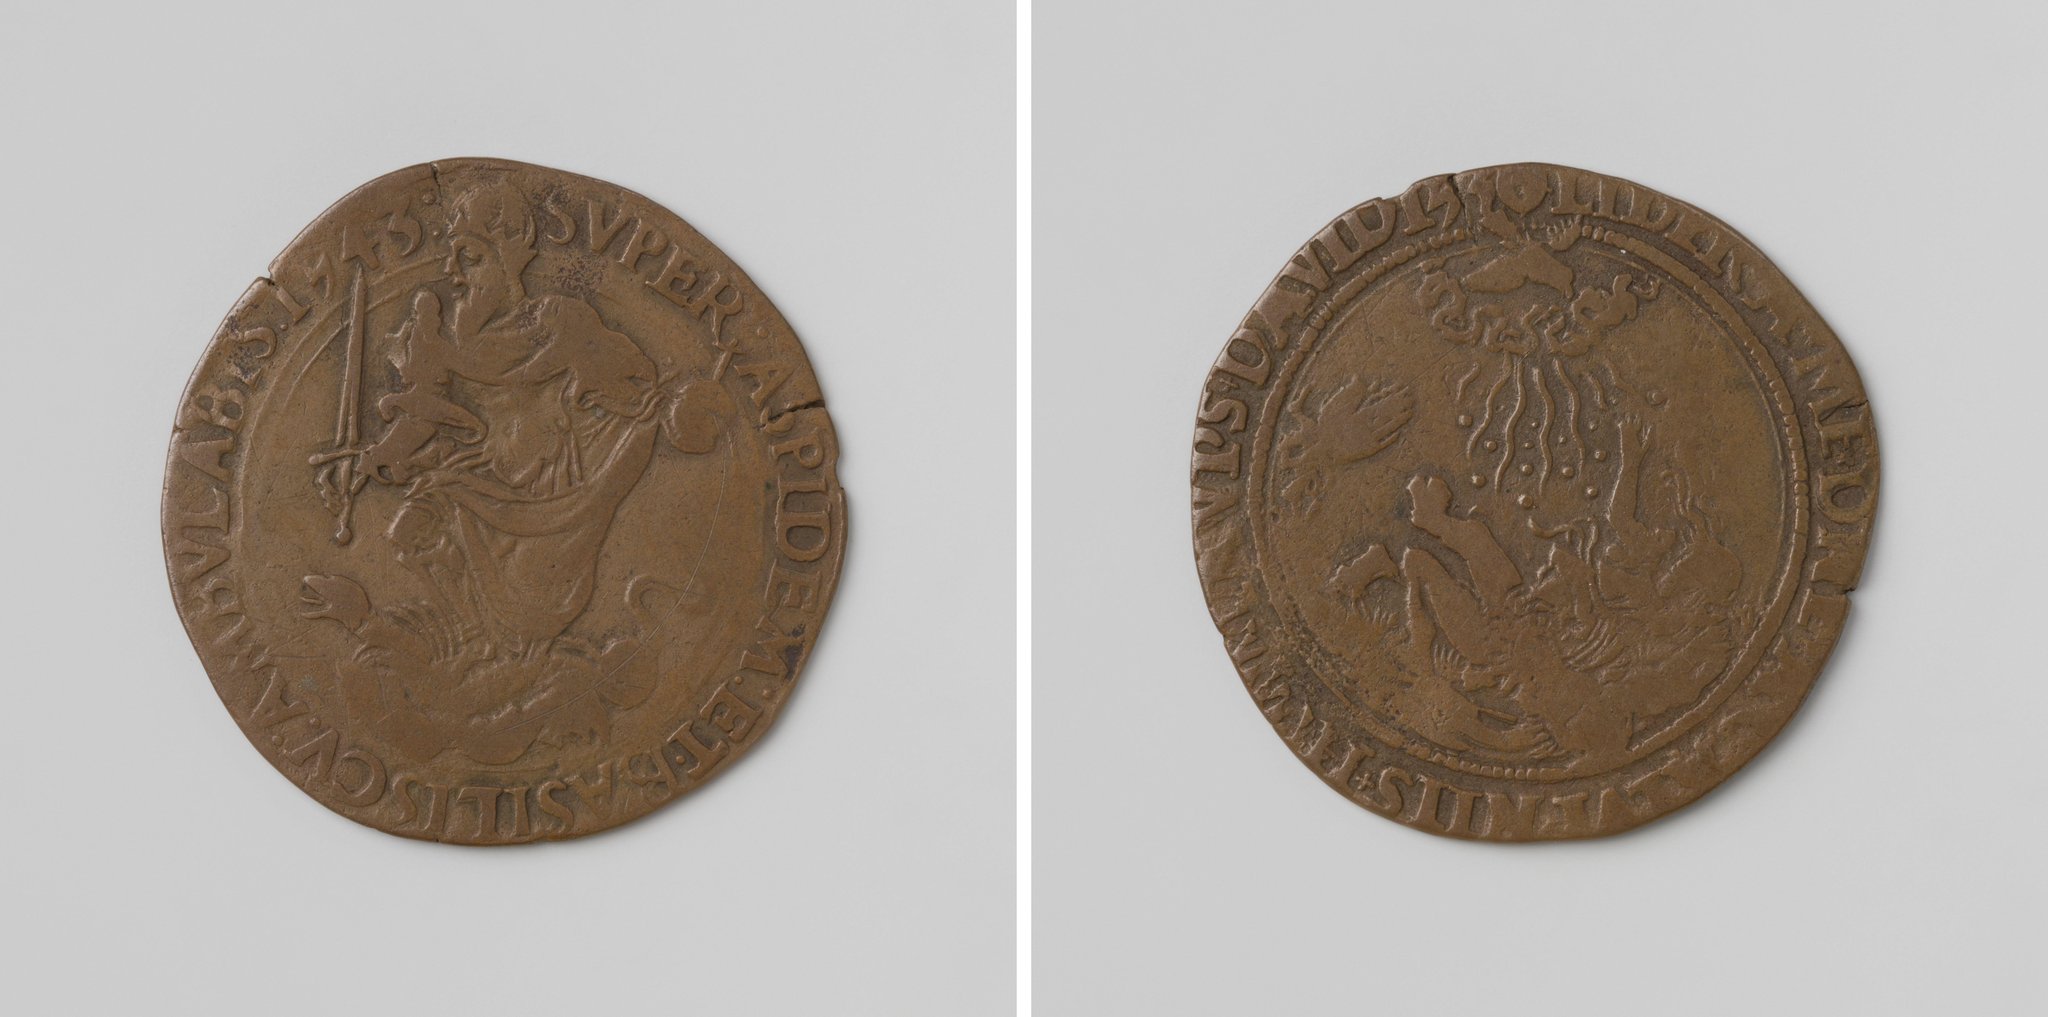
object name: jeton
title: Karel V, Duits keizer, bereidt zich voor op de oorlog tegen Frankrijk en Gelderland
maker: Anonymous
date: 1543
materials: copper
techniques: striking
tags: ghent, charles v (holy roman emperor and king of spain), france, gelderland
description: Koperen penning. Voorzijde: portret van Karel V met kroon, rijksa: el in linker- en zwaard in rechterhand, staande op ter aarde liggende slang Aspis en monster Basiliscus binnen omschrift. Keerzijde: Heilige Geest, afgebeeld als duif in wolken, treft met stralen uit hemel ter aarde liggende man en vrouw; links twee handen uit wolk binnen omschrift